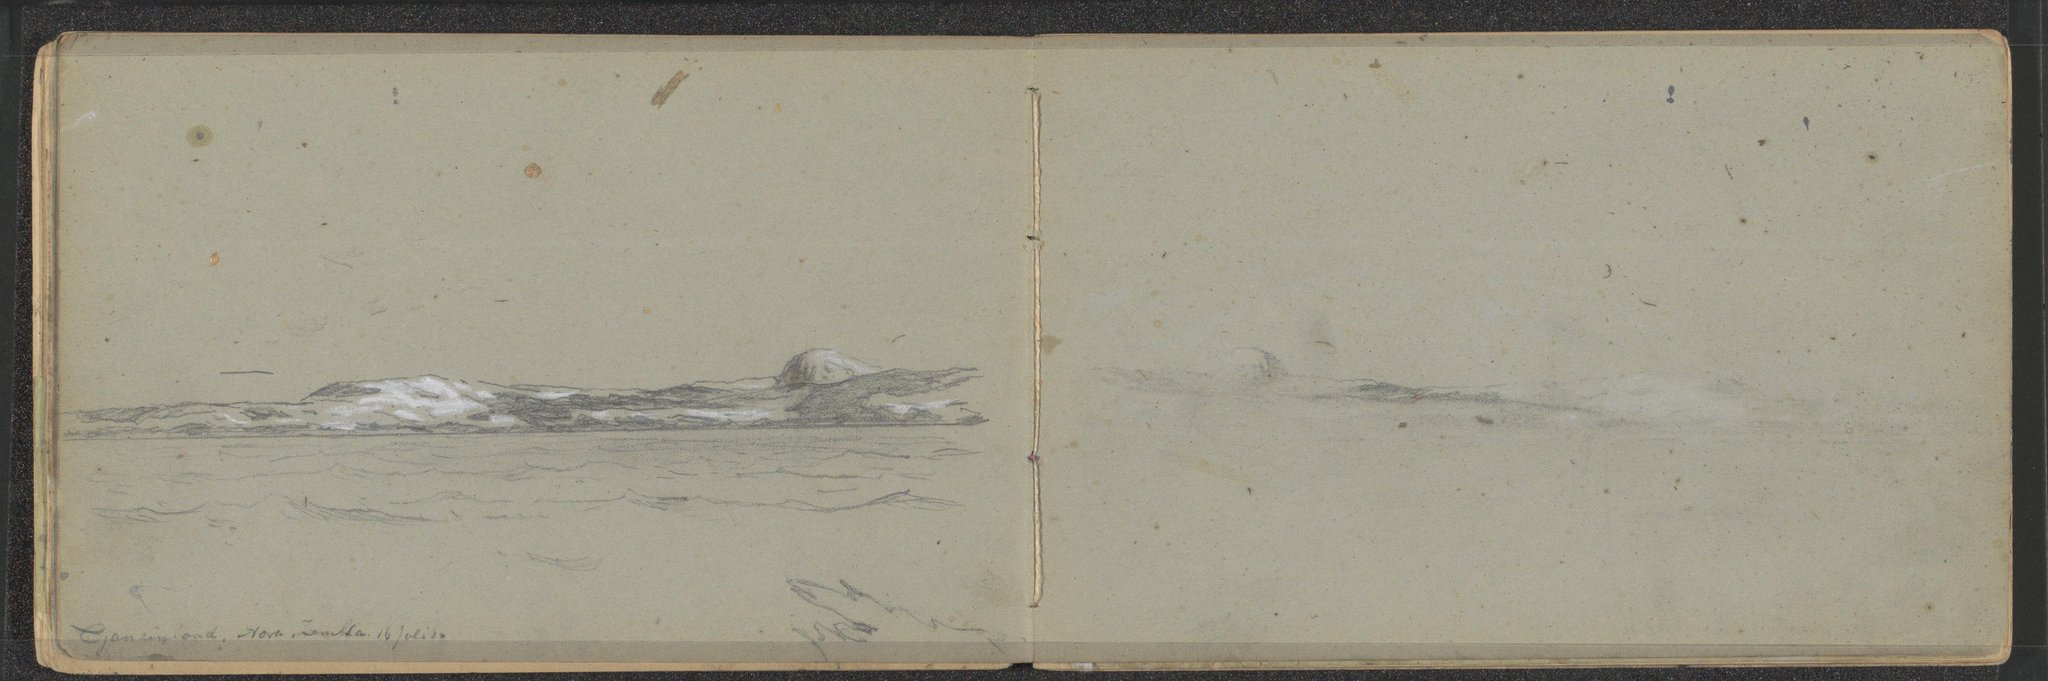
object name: sketchbook leaf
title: Gezicht op Goesinaja Zemlja (Ganzenland), Nova Zembla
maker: louis apol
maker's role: draughtsman, painter, print maker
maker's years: 1850-1936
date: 1880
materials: chalk, paper, pencil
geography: goesinaja zemlja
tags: island (in polar regions), sea (seascape)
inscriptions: annotation: ‘Ganzenland, Nova Zembla.’, date: ‘16 Juli 80’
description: Blad 20 verso uit een schetsboek met 35 bladen betekend tijdens de expeditie naar Nova Zembla in 1880.